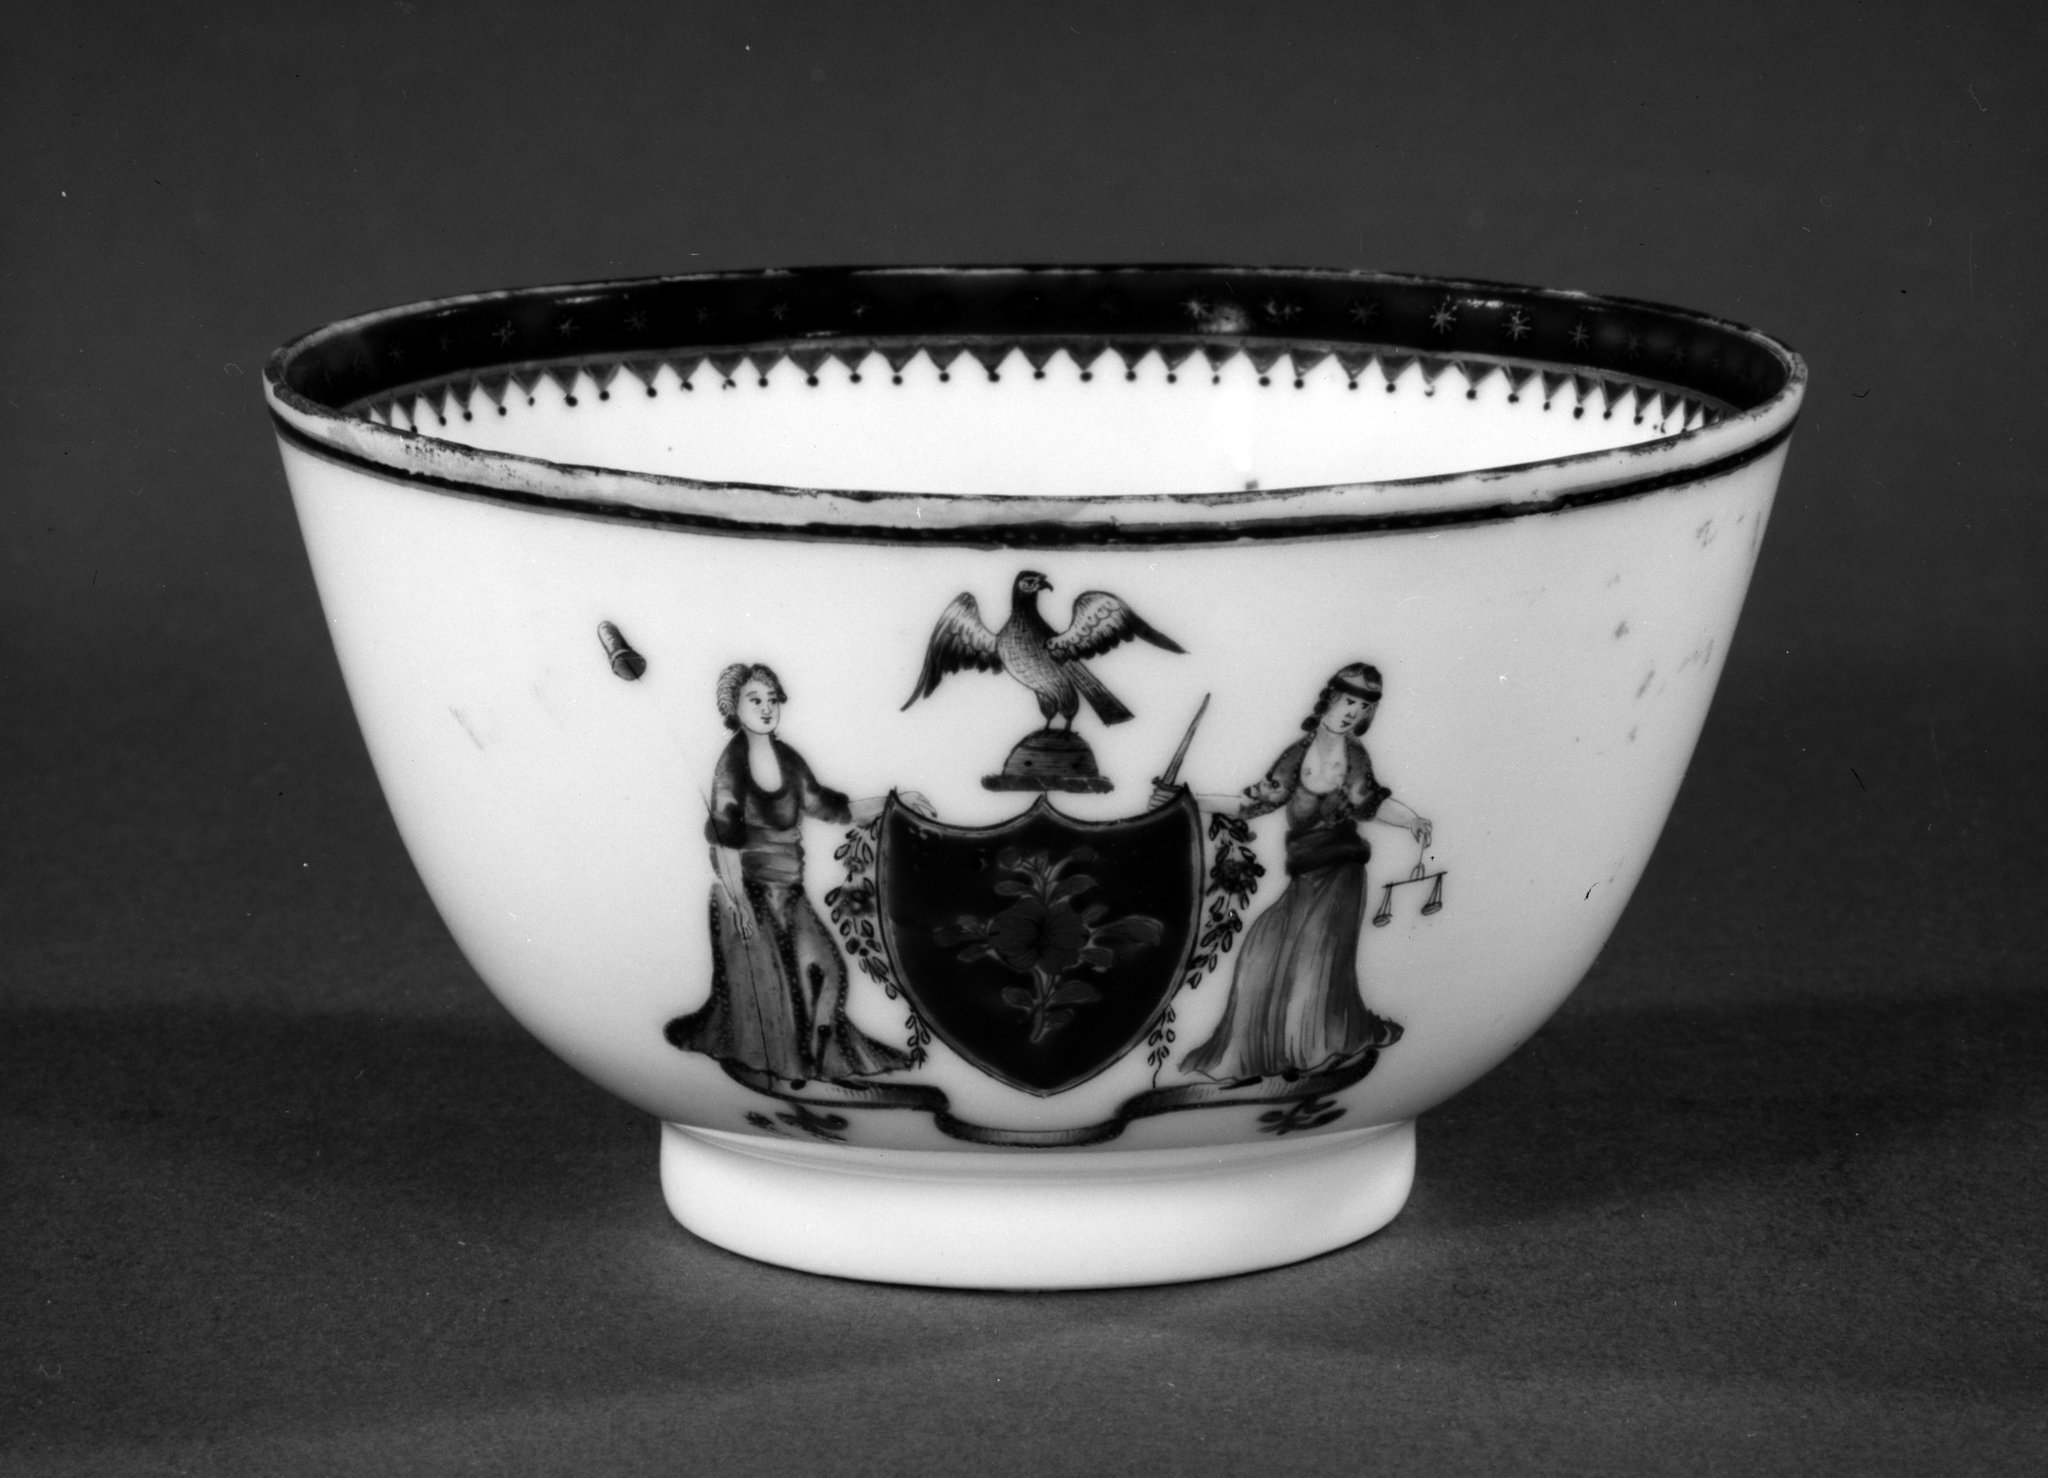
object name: cup and saucer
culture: chinese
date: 1770-1800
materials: porcelain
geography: china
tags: coat of arms